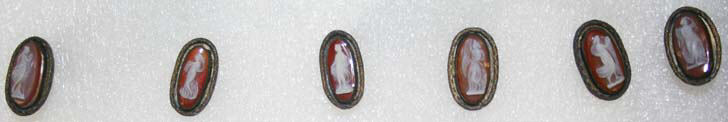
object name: button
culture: italian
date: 1880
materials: metal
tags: cameos